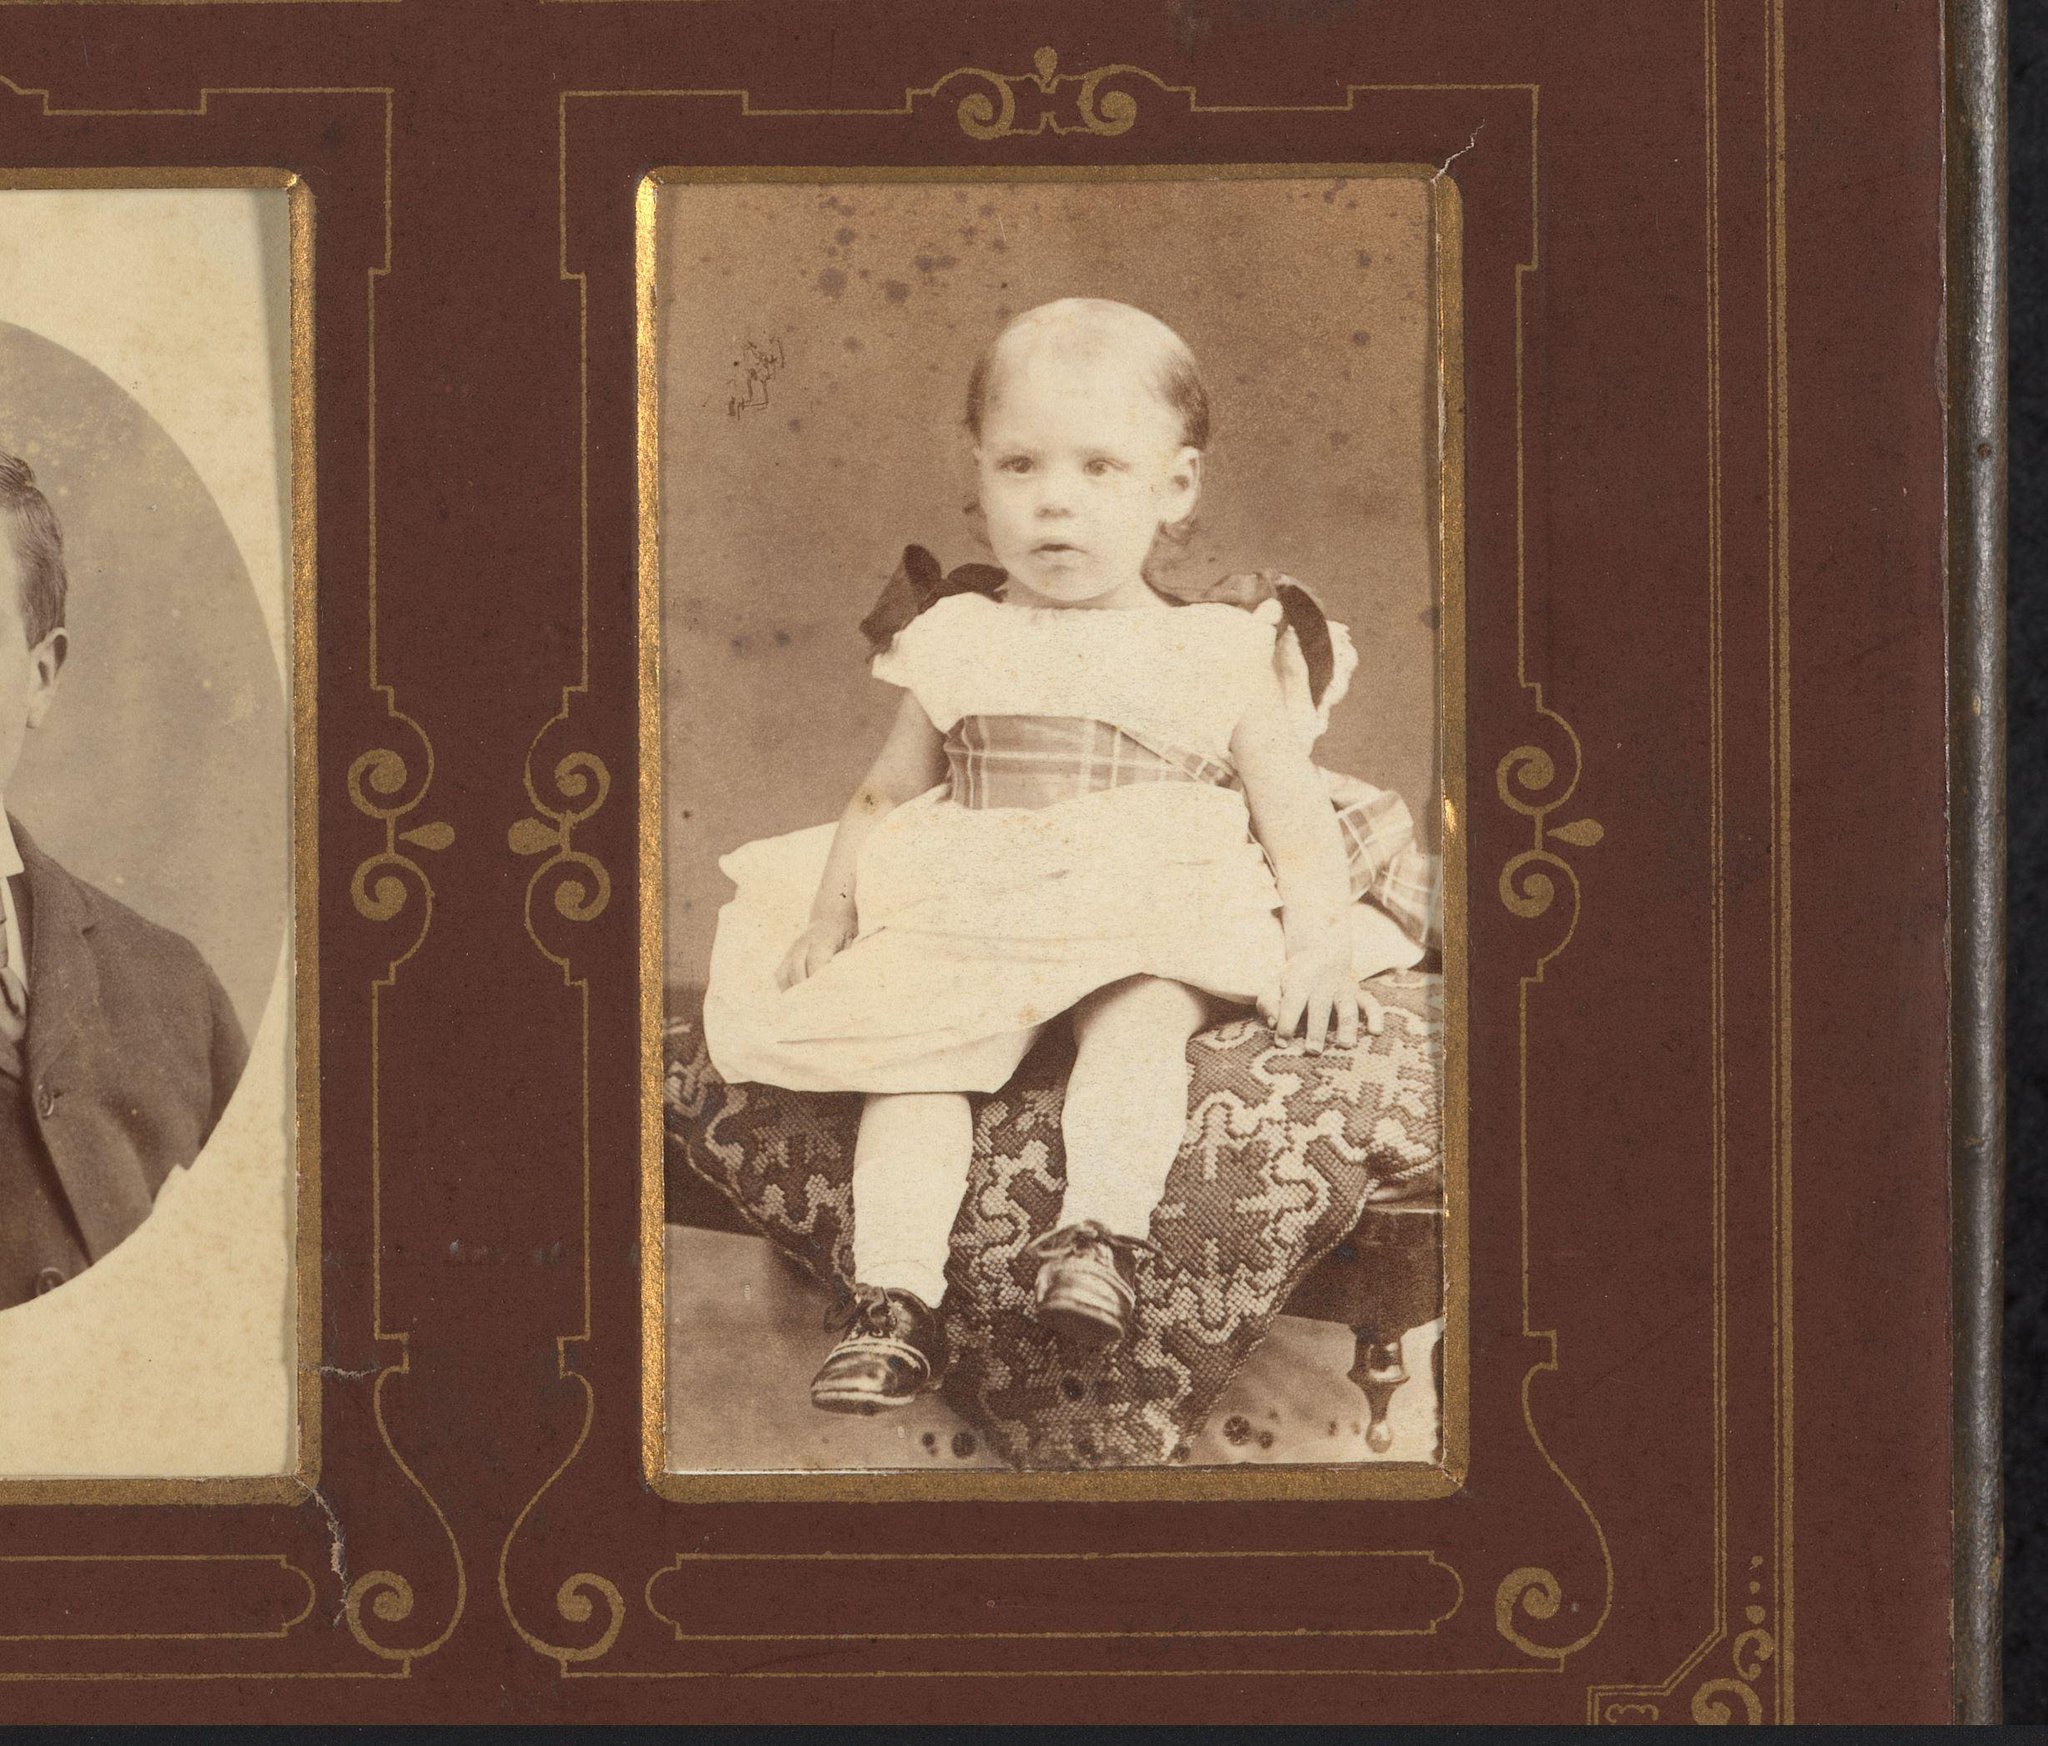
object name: carte de visite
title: Portret van een zittend meisje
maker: elizabeth mitton hind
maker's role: fotograaf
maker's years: 1852-1926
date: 1881-1900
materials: cardboard, photographic support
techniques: albumen print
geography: london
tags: historical persons - bb - woman, girl (child between toddler and youth)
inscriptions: inscription: ‘E.M. hind/ Photographer (...)’